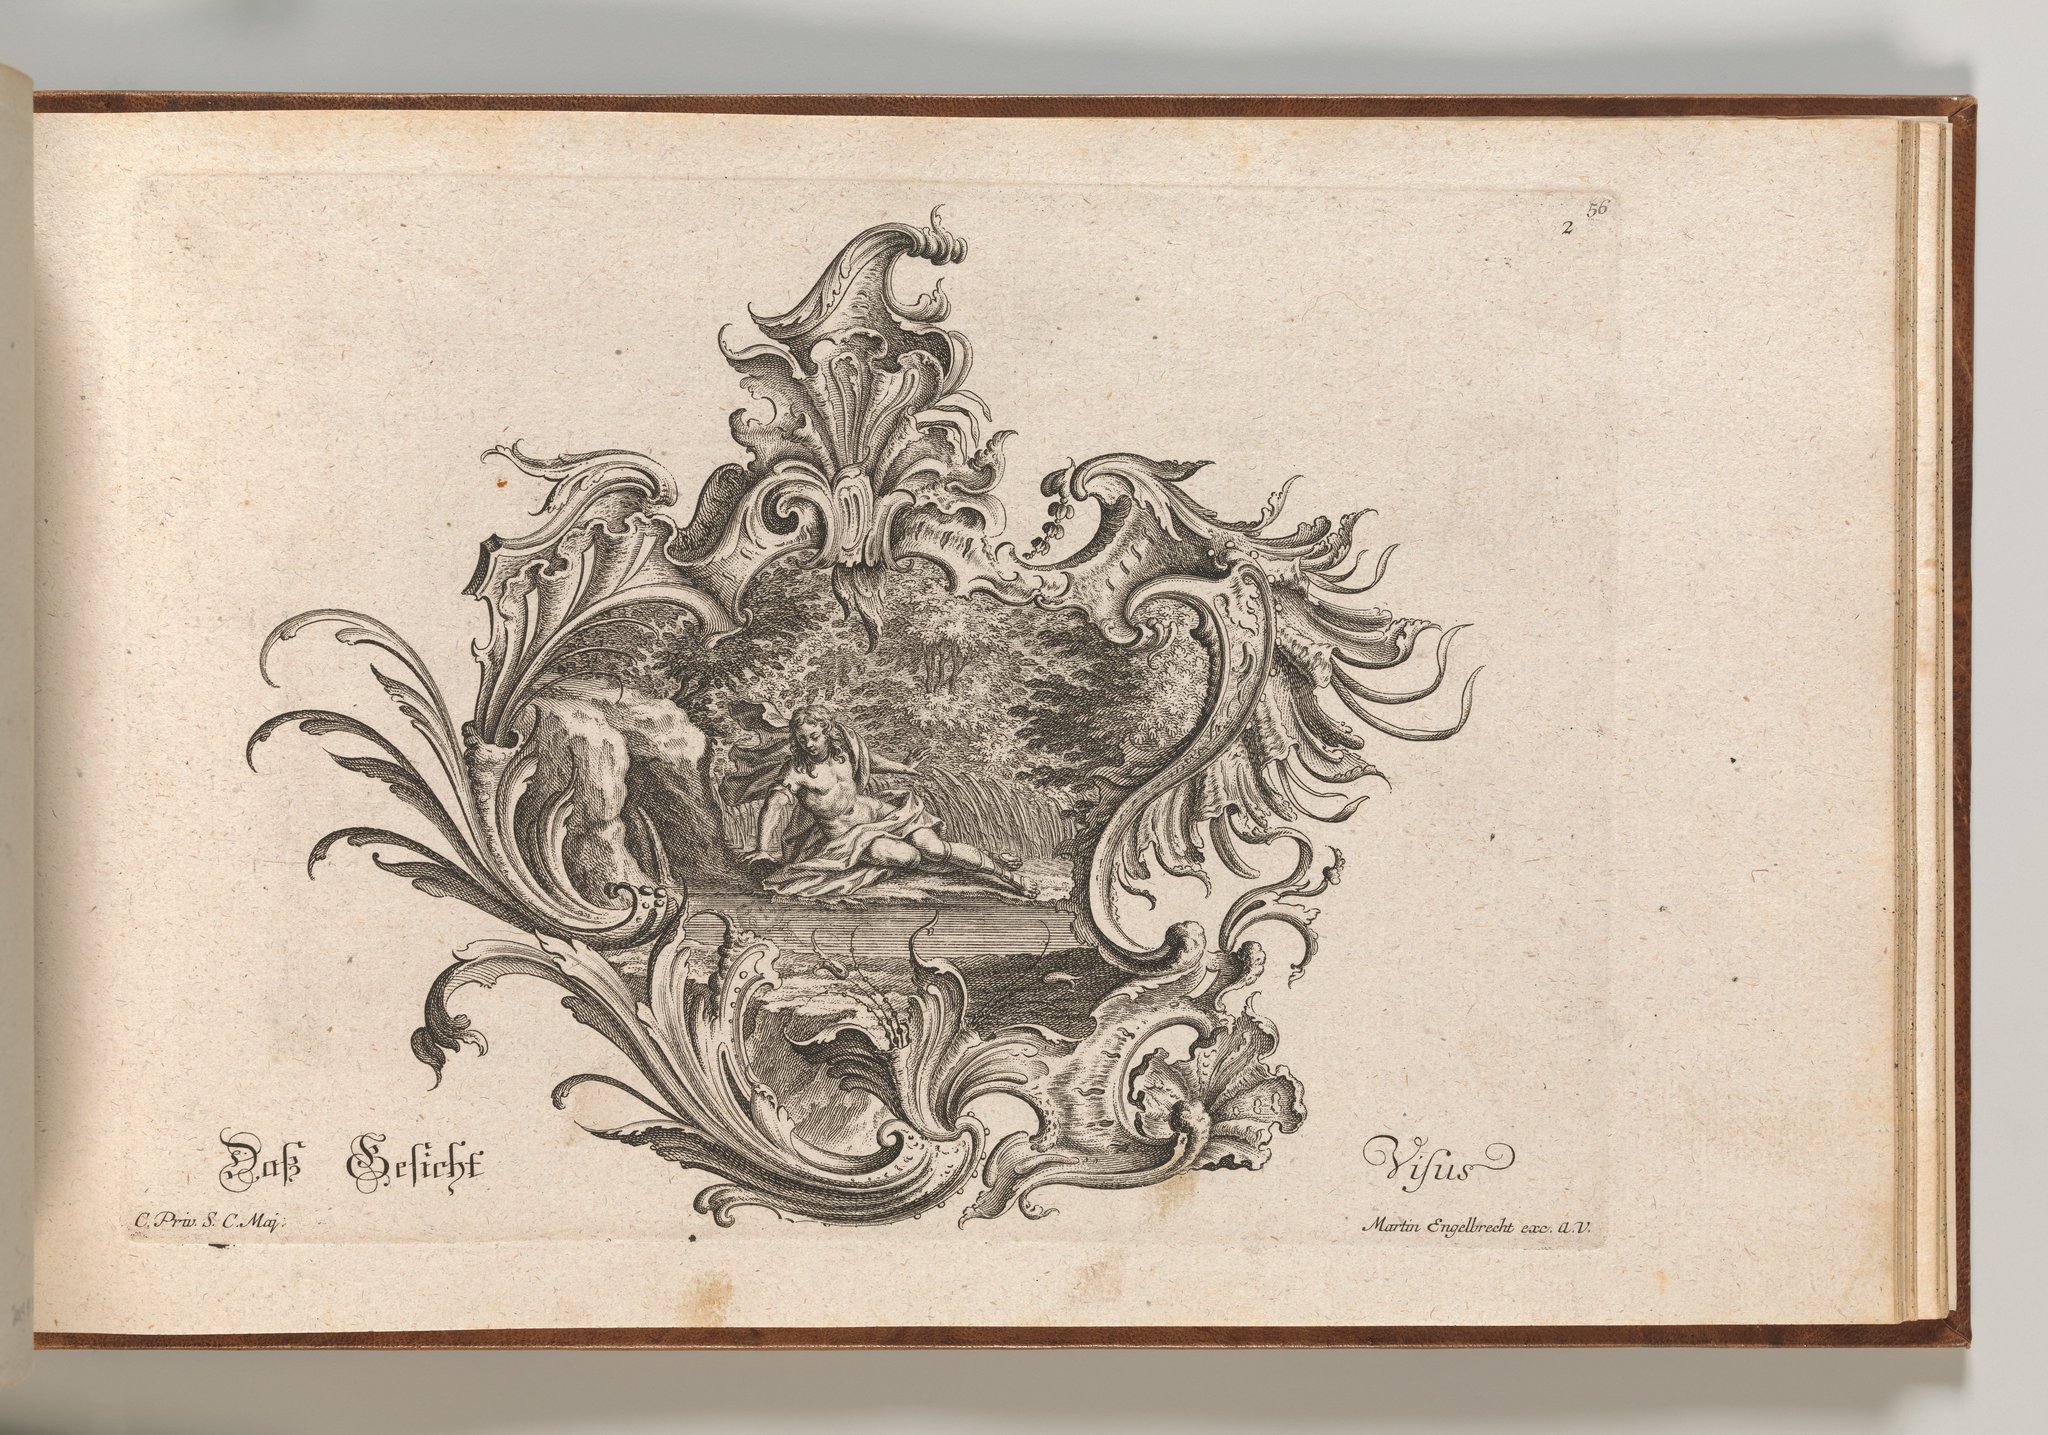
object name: album print ornament architecture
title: Design for a Cartouche and Representation of 'Sight', Plate 2 from 'Neu Inventierte auf die artigste Facon Sehr nutzliche Schild.'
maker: johann georg pintz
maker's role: engraver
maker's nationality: central european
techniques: etching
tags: men,narcissus